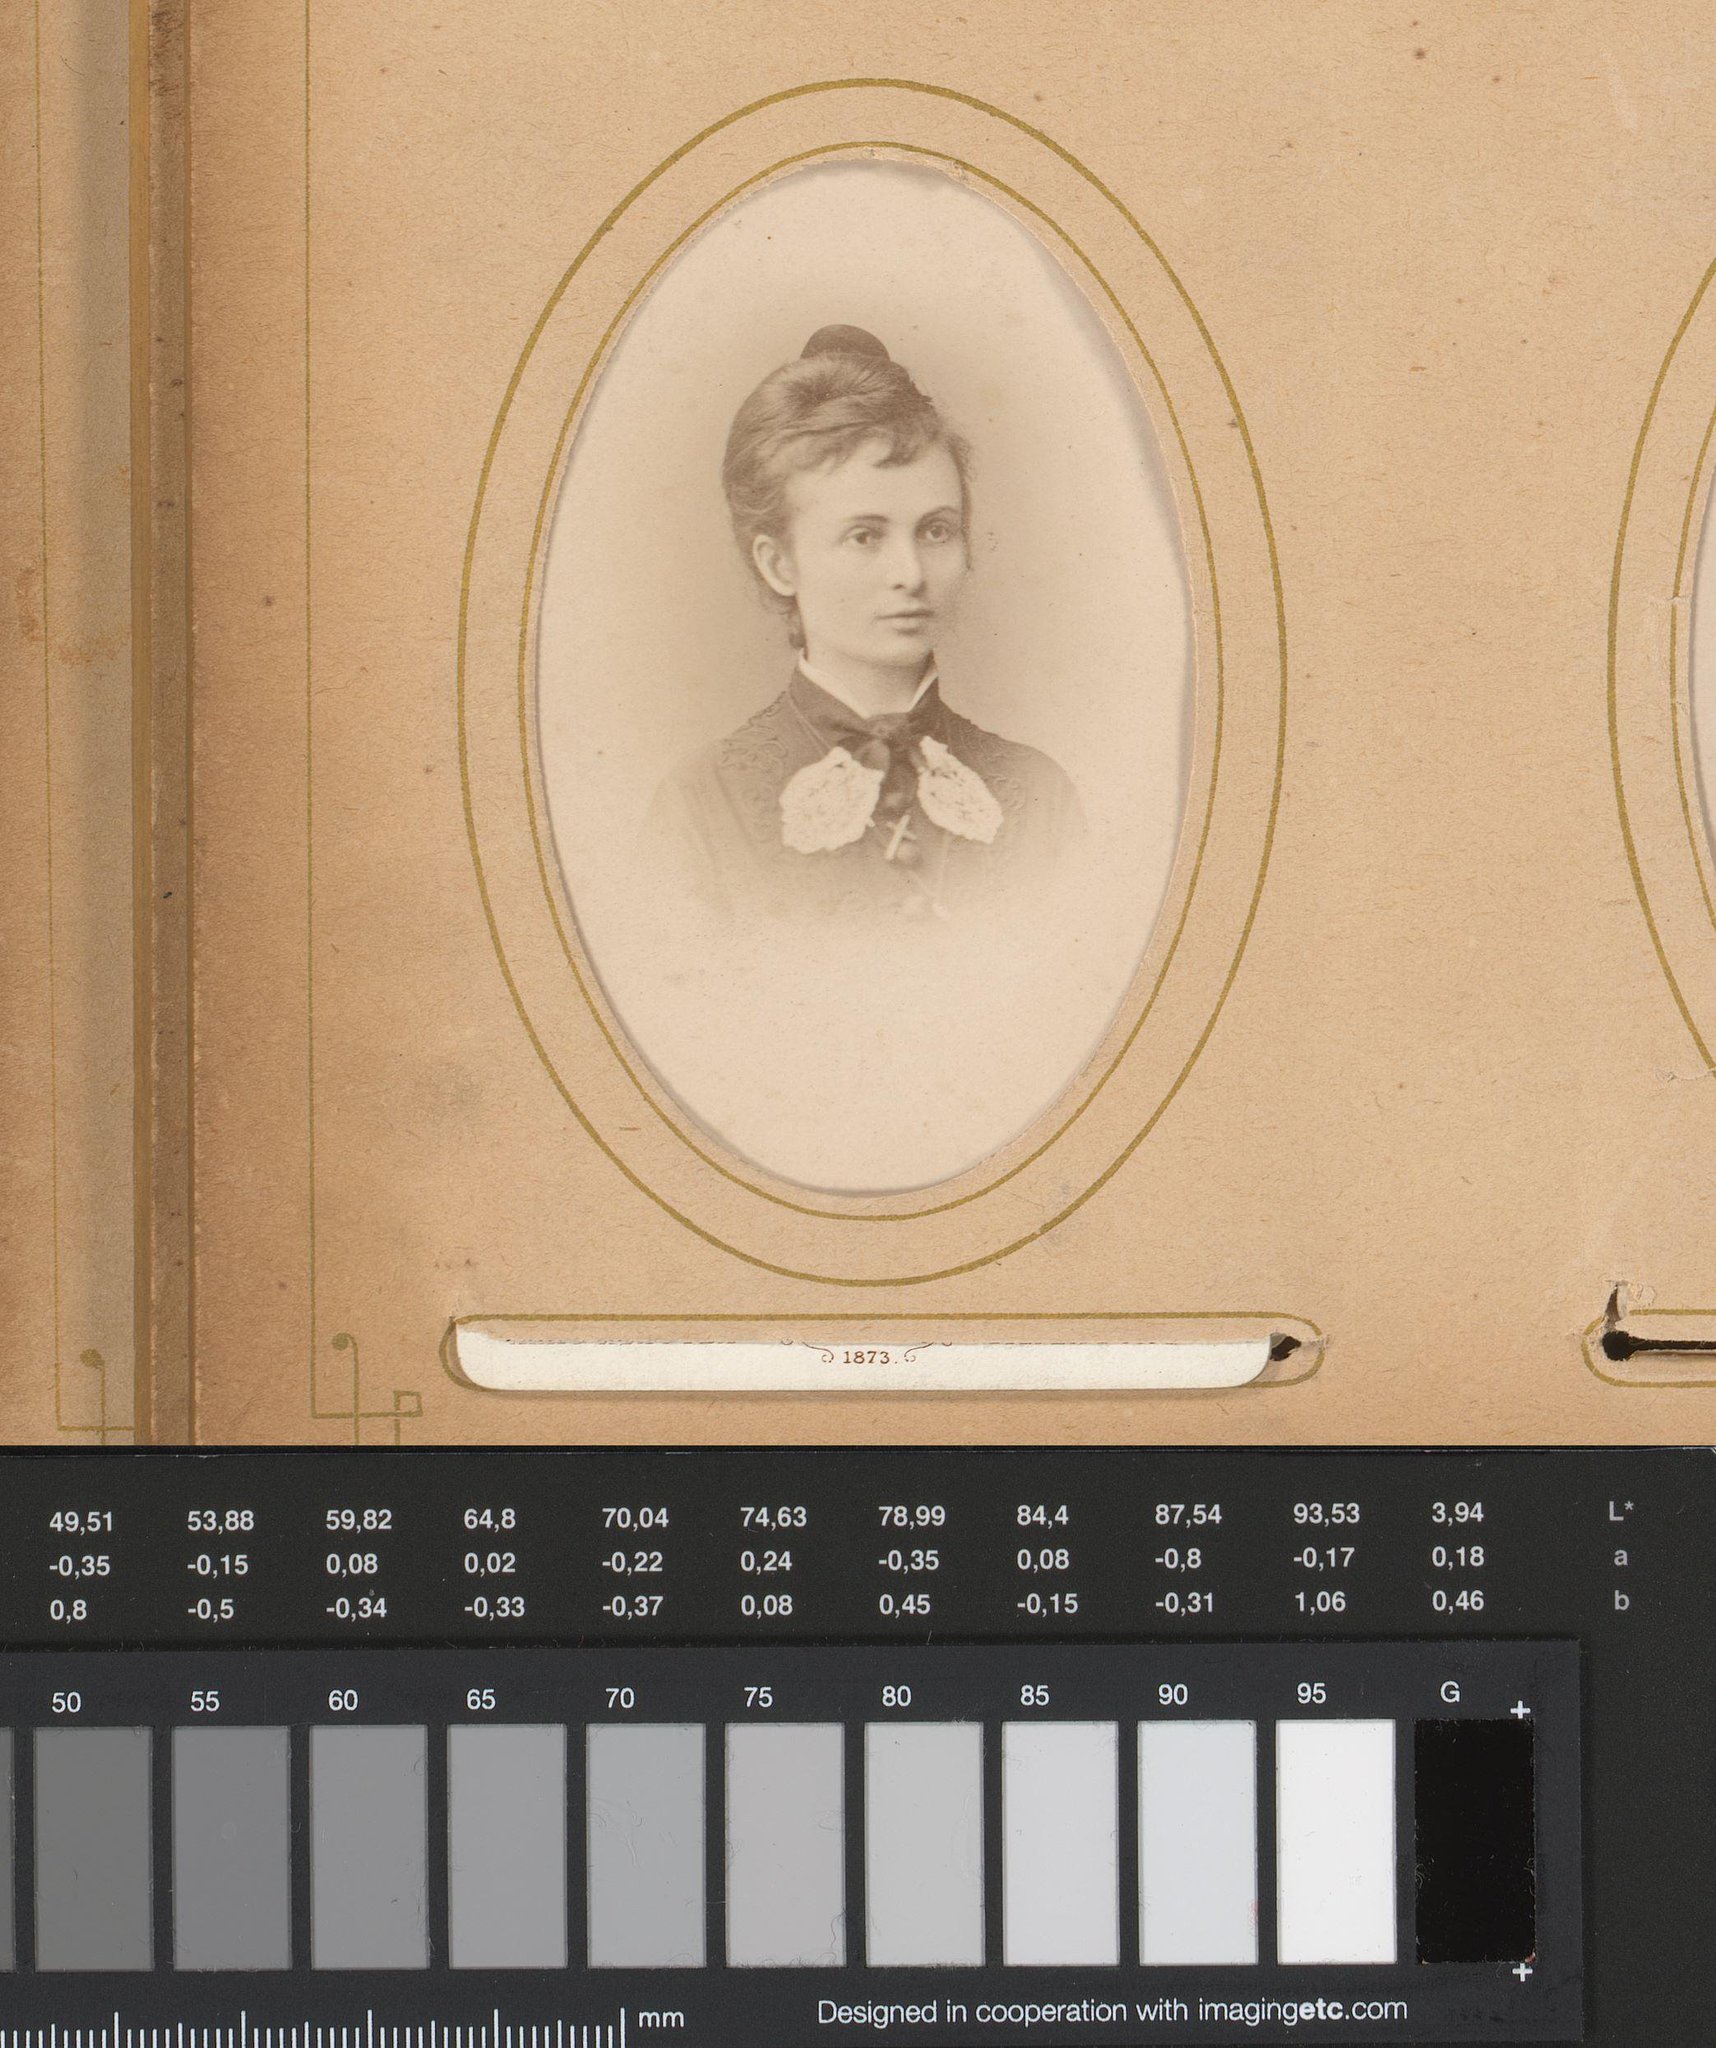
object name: photograph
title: Portret van een jonge vrouw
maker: arno kersten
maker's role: fotograaf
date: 1860-1900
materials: cardboard, photographic support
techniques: albumen print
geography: altenburg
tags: adolescent, young woman, maiden, historical persons - bb - woman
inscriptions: inscription: ‘Arno Kersten/ Hof-Photograph Altenburg i/S./ Albrechtstrasse 9. Ecke der Lindenaustrasse.’